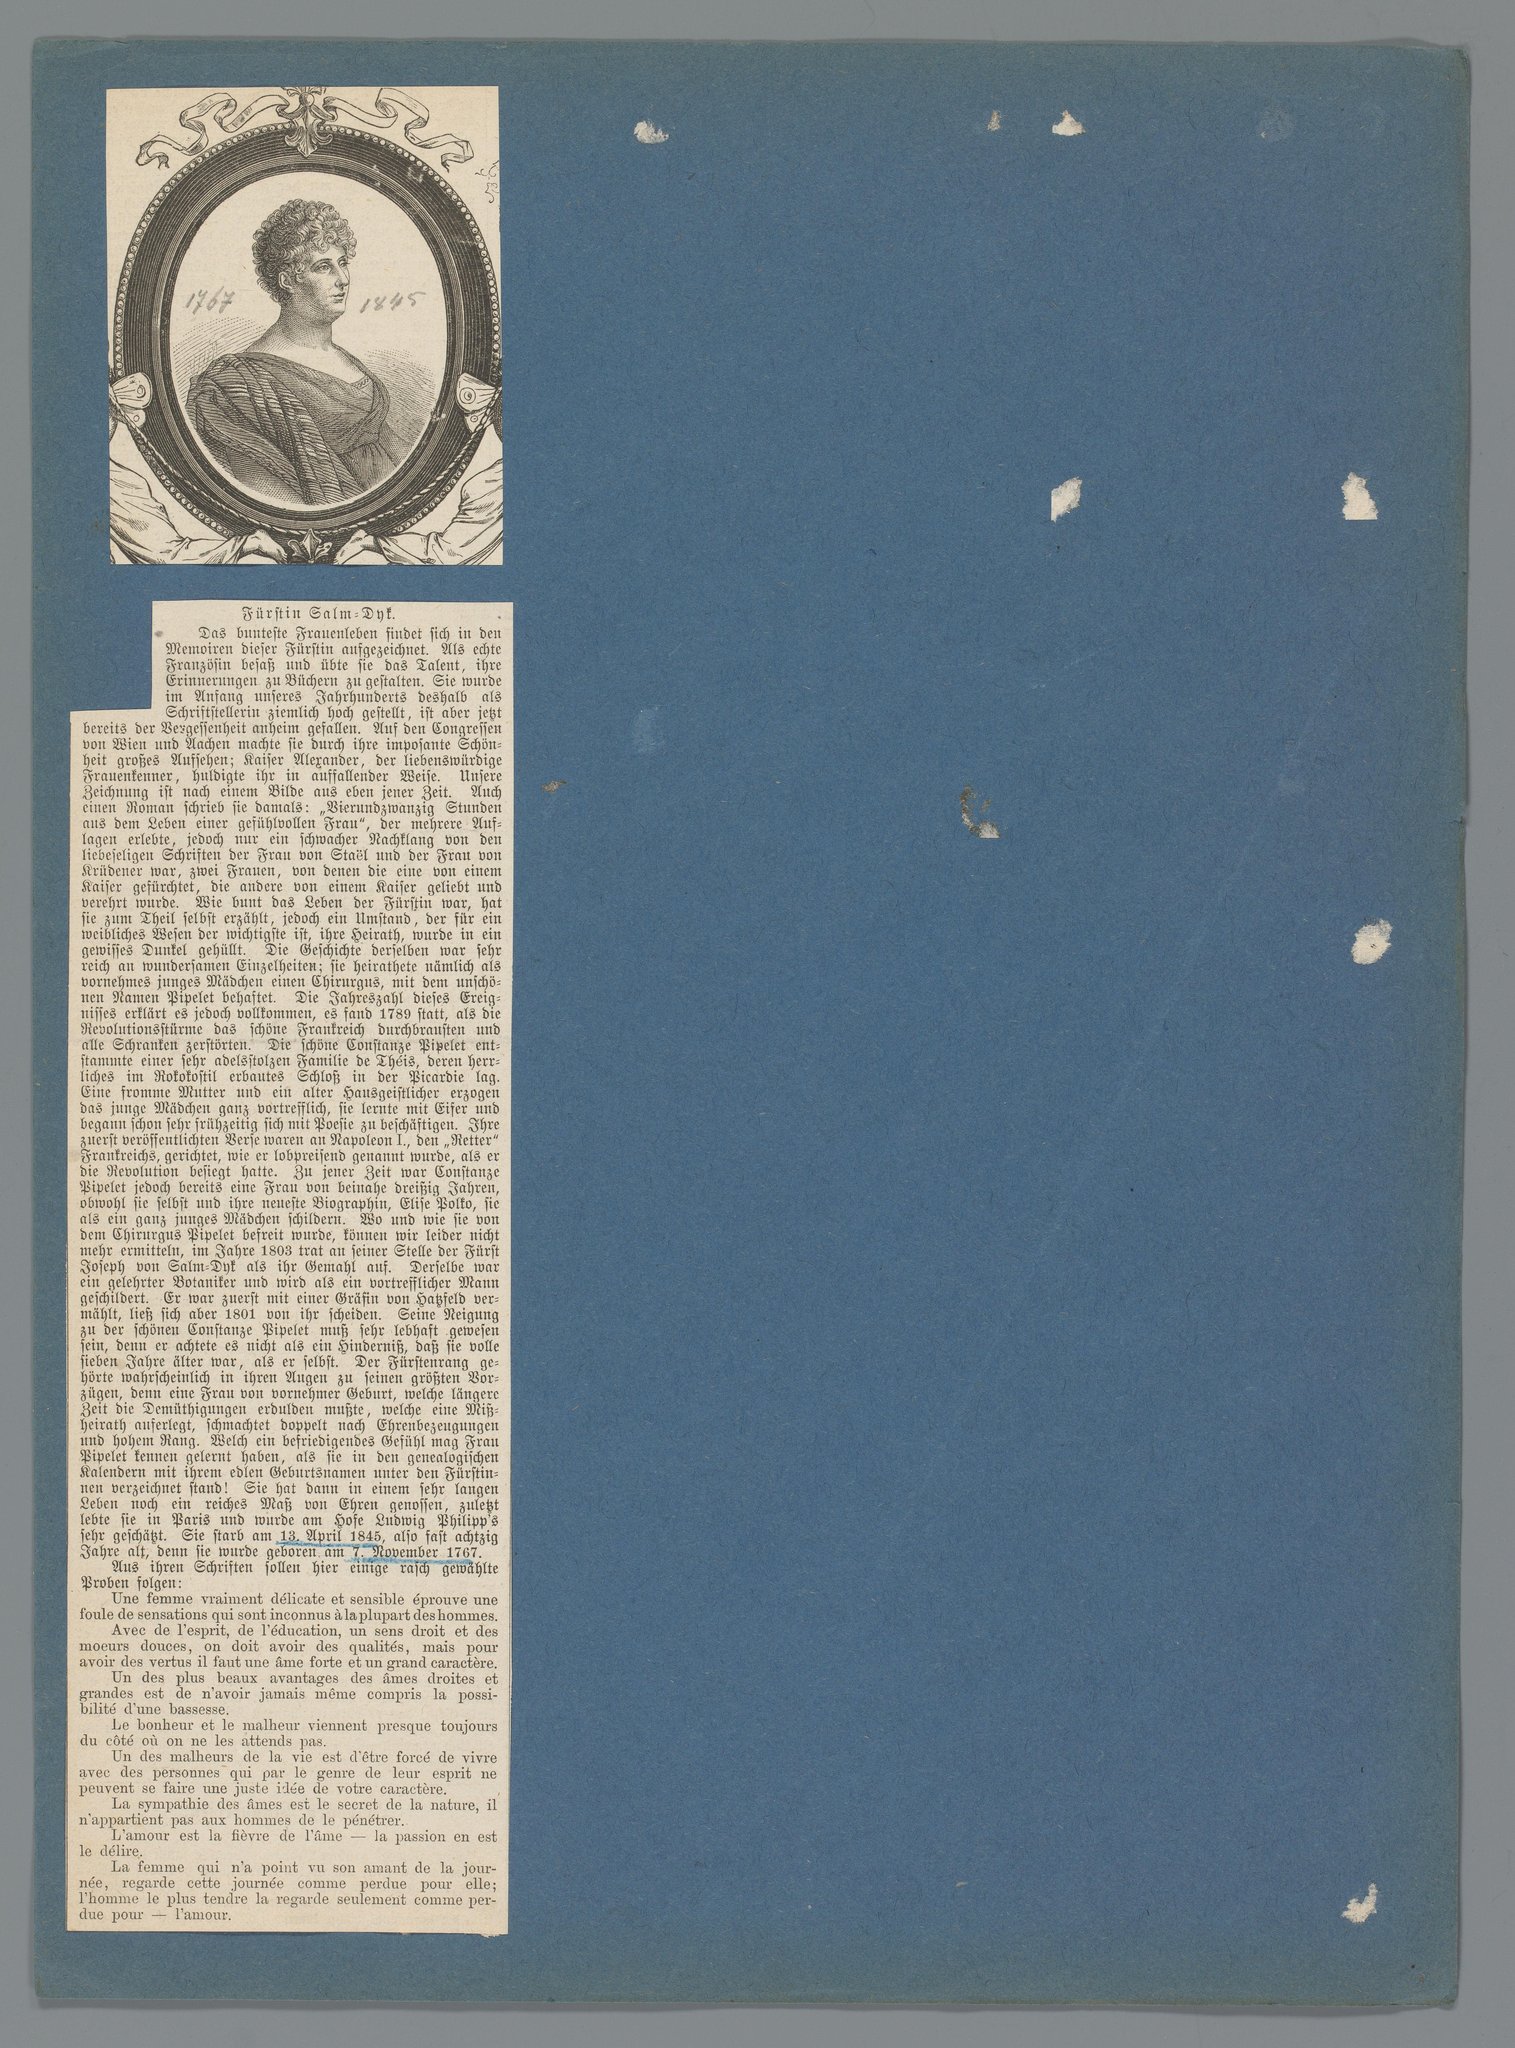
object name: print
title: Blad met één portret van Constance de Théis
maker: Anonymous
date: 1850-1900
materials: paper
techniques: letterpress printing, snipping, engraving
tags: historical persons - bb - woman, portrait of a writer